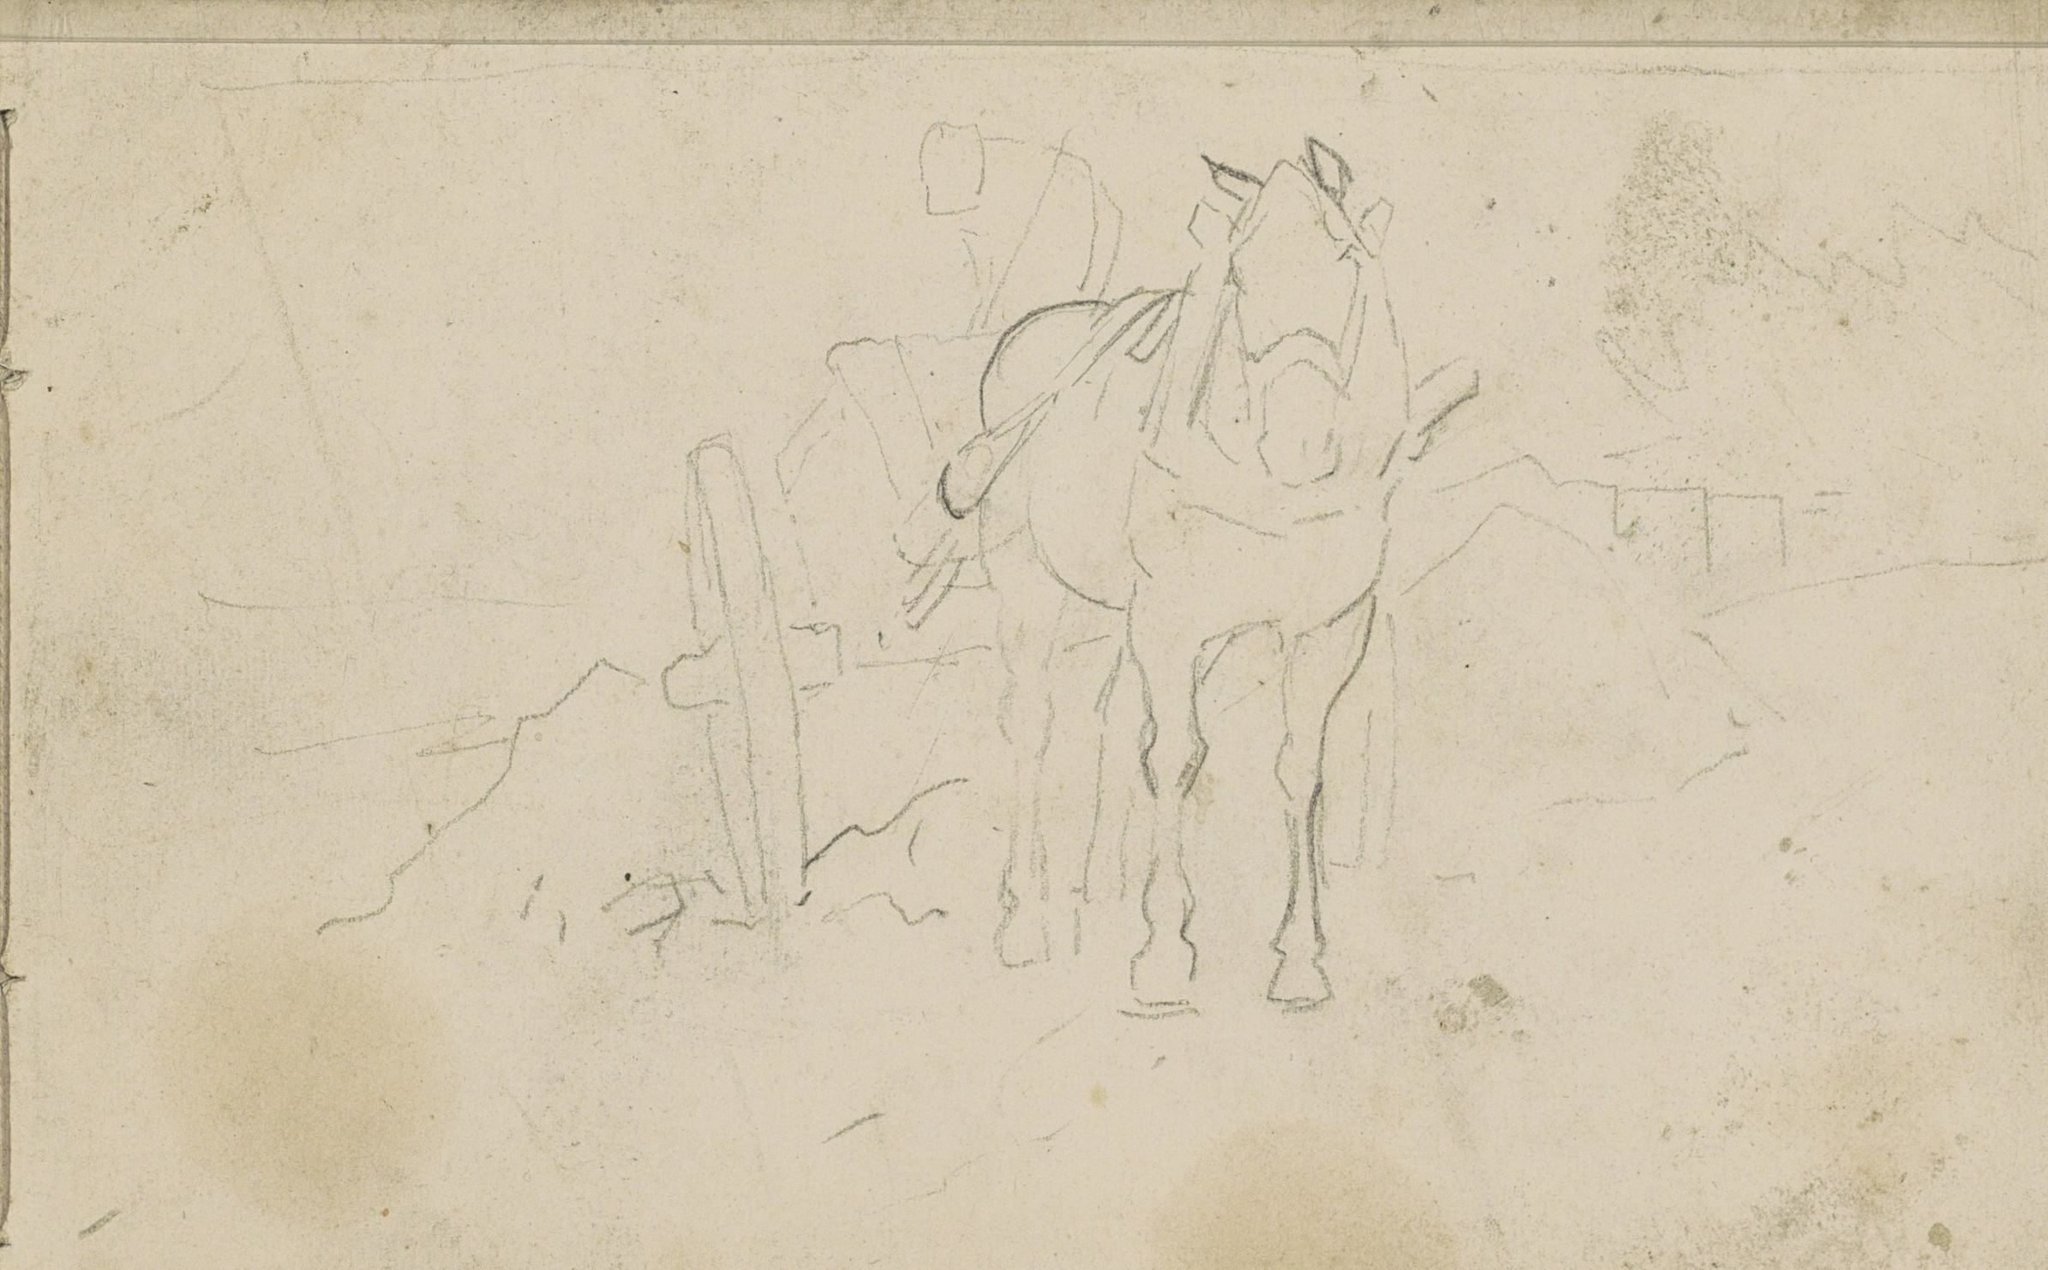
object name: sketchbook leaf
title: Trekpaard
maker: anton mauve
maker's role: draughtsman, painter, print maker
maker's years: 1838-1888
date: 1848-1888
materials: chalk, paper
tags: horse, (farm) wagon, freight wagon, cart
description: Het paard trekt een kar voort waarop een figuur staat. Blad 18 recto uit een schetsboek met 42 bladen.